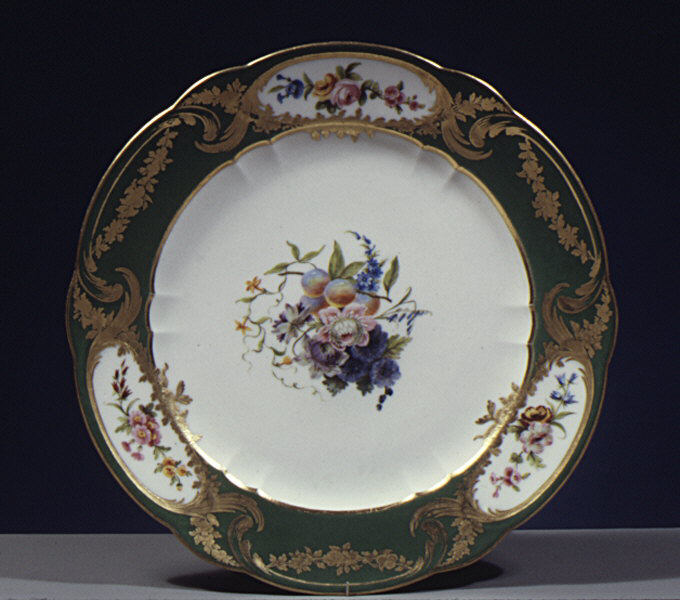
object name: plate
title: Plate (assiette à palmes) (1 of 102) (part of a service)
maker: sèvres manufactory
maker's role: manufactory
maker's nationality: french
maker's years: 1740-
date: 1786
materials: soft paste porcelain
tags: fruit,flowers